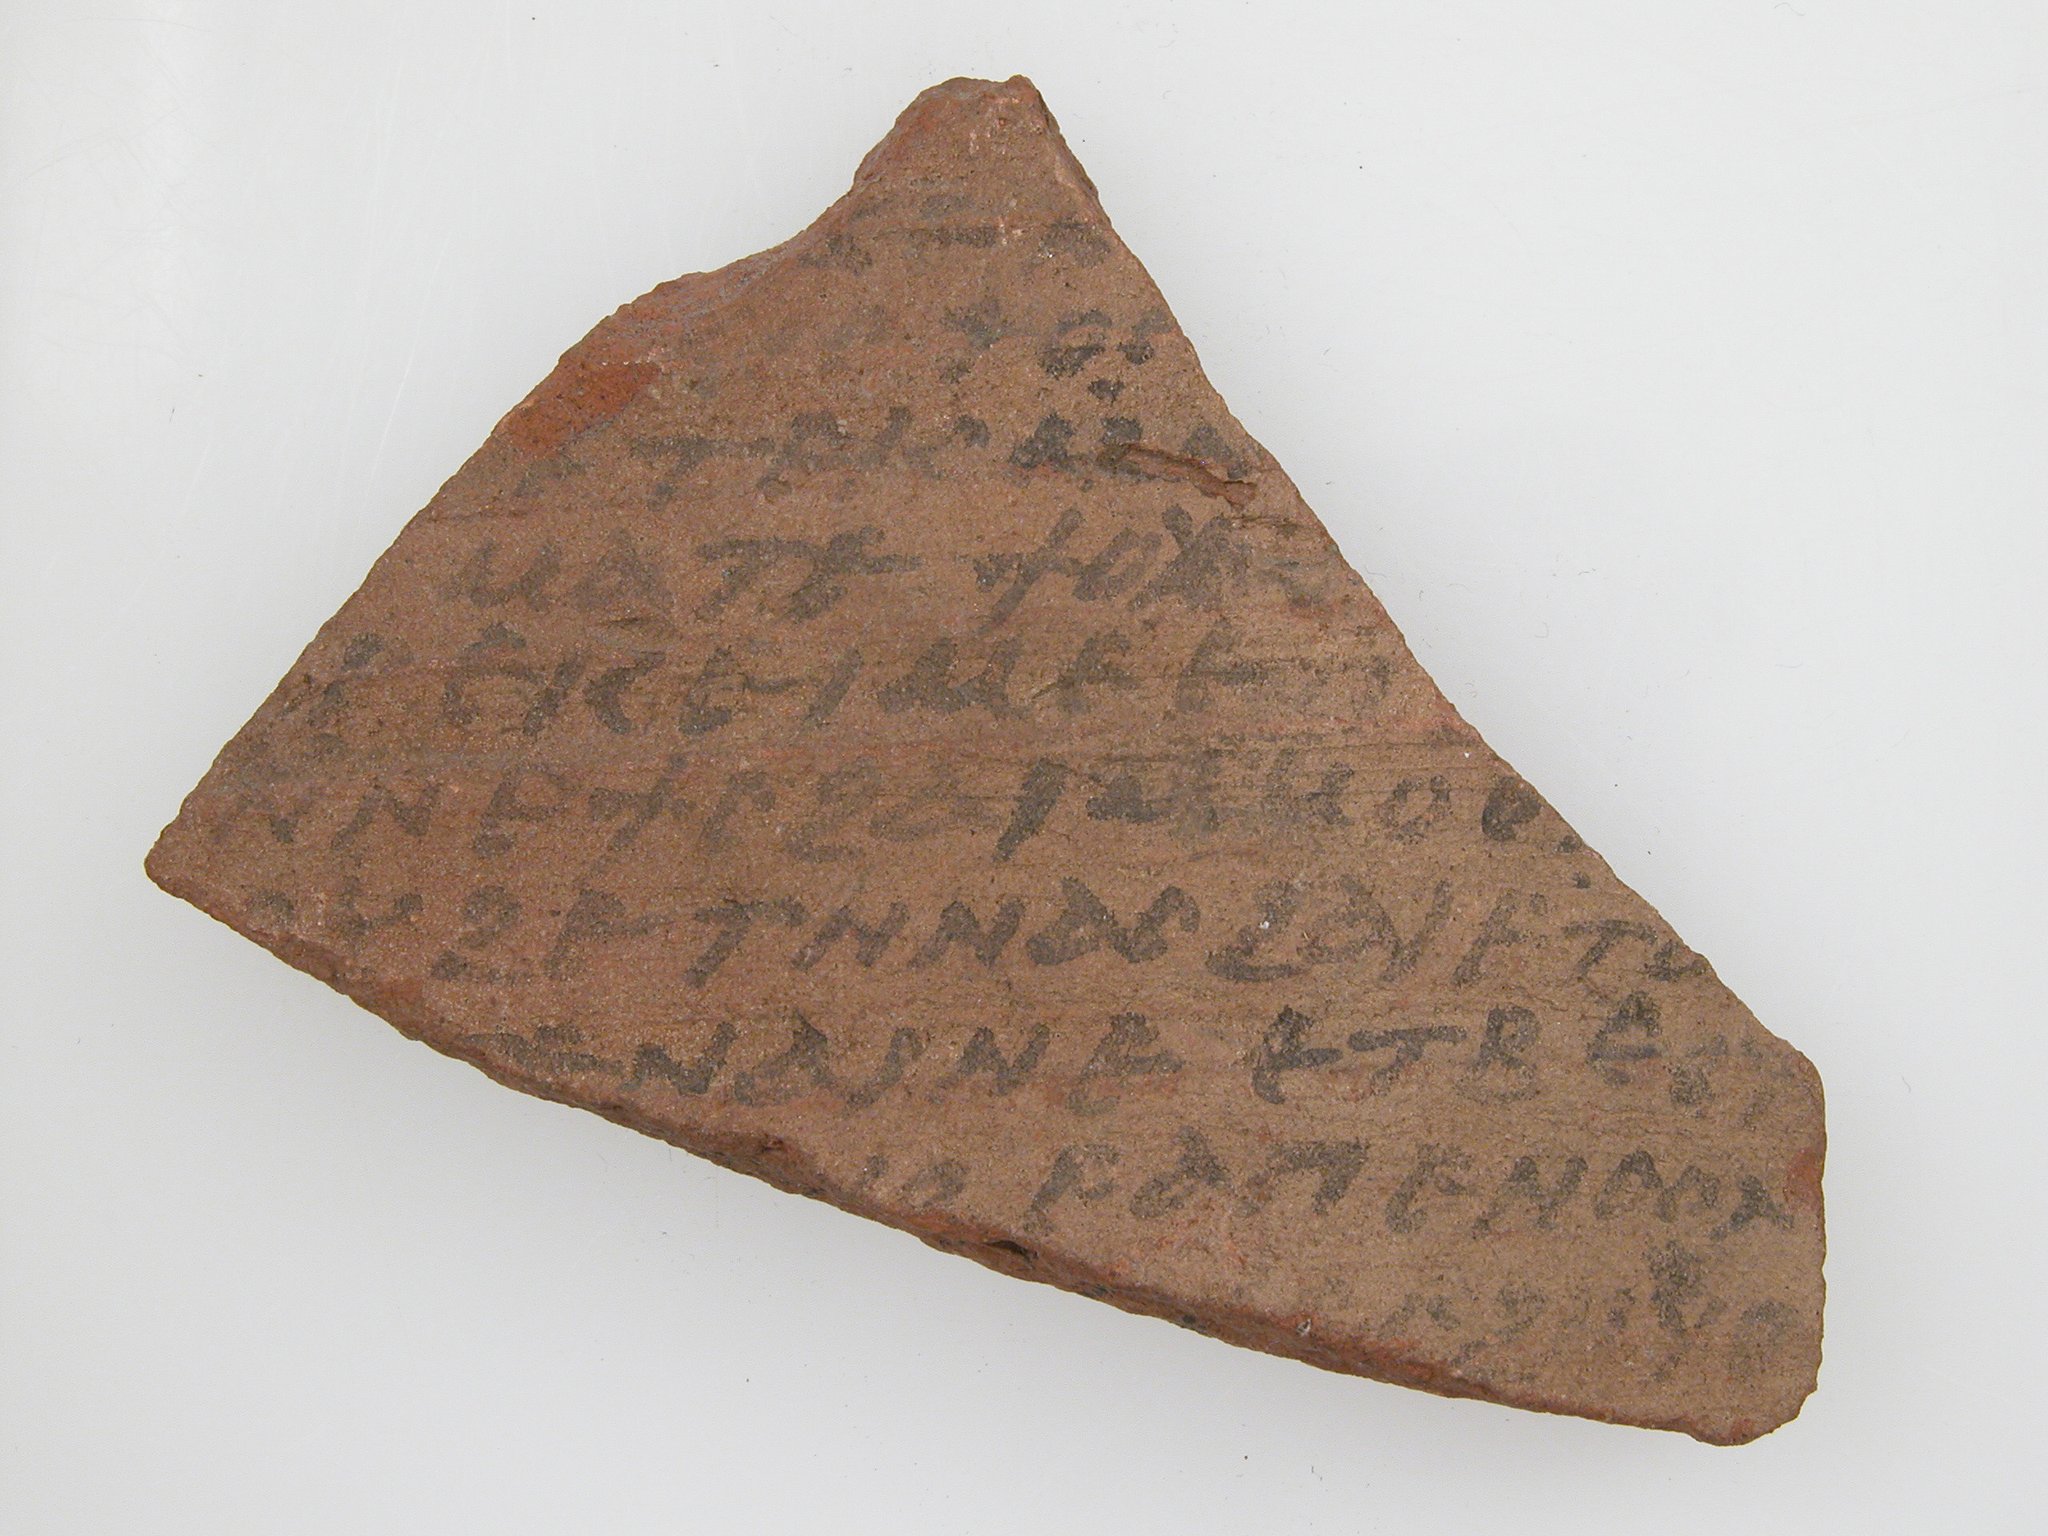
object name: ostrakon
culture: coptic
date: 601-700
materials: ink, pottery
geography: egypt